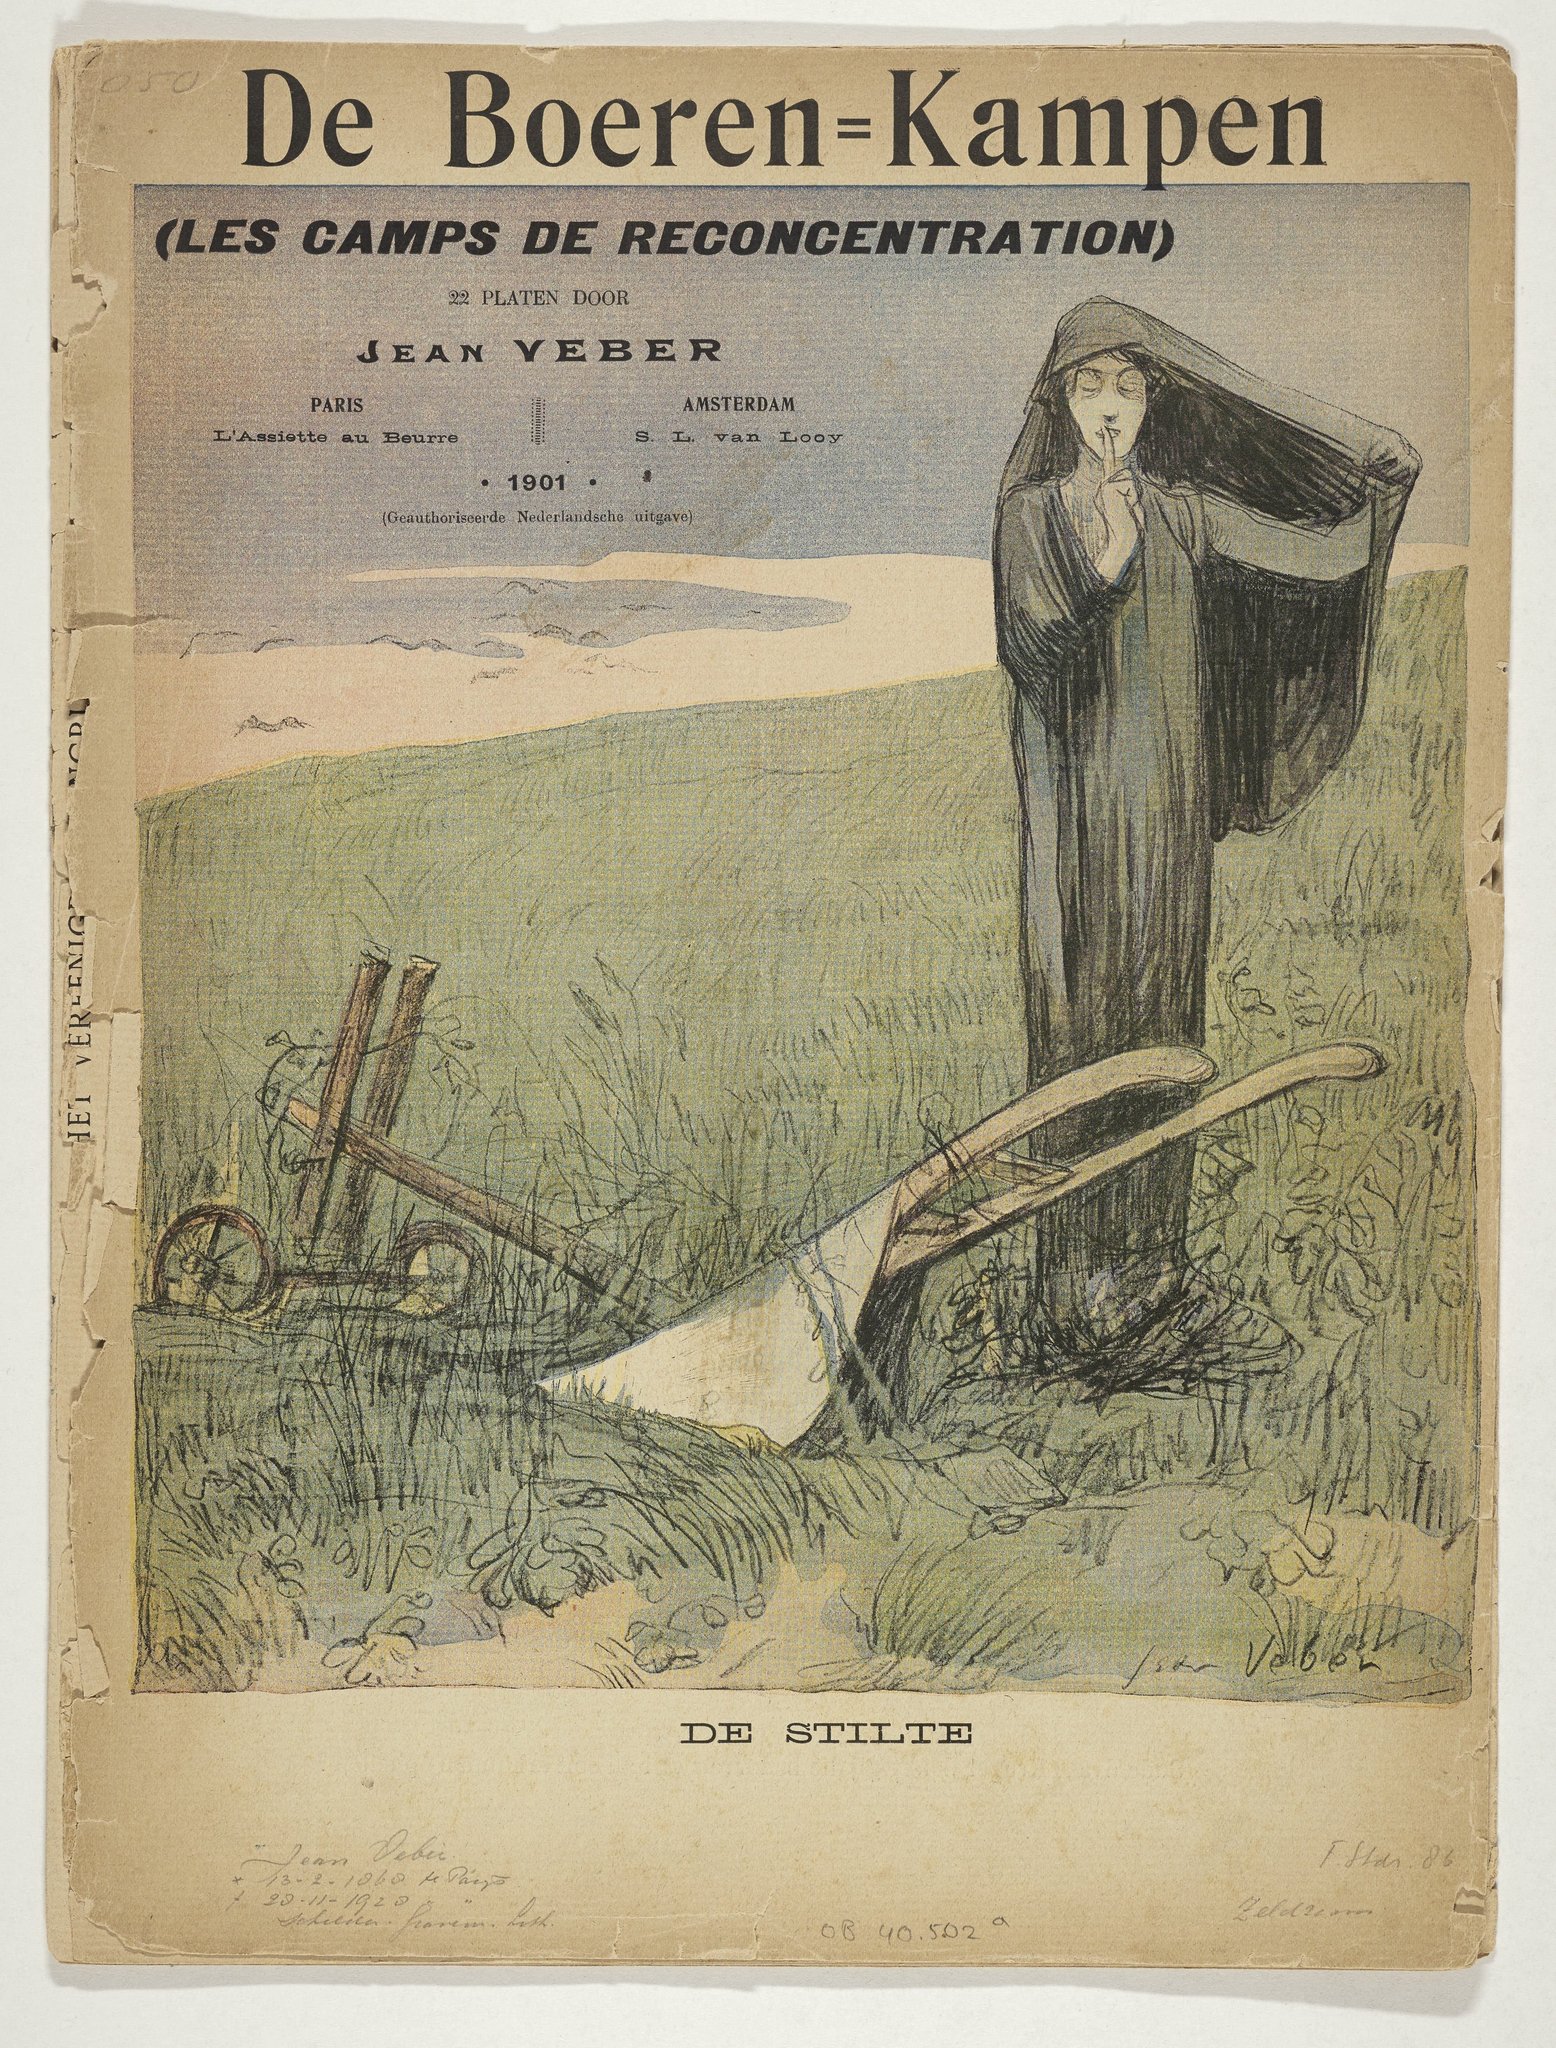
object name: page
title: Gesluierde vrouw (de Dood) gebaart om stilte naast een ploeg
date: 1901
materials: paper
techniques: lithograph, letterpress printing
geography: amsterdam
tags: death as man - ff - death as female, agricultural implements: plough, political caricatures and satires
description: Prent uit: De Boeren-Kampen / (Les camps de reconcentration), 1901. Dit is de geautoriseerde Nederlandse uitgave van: L'Assiette au Beurre 1 (1901), nr. 26 (Les camps de reconcentration au Transvaal), 28 september 1901.